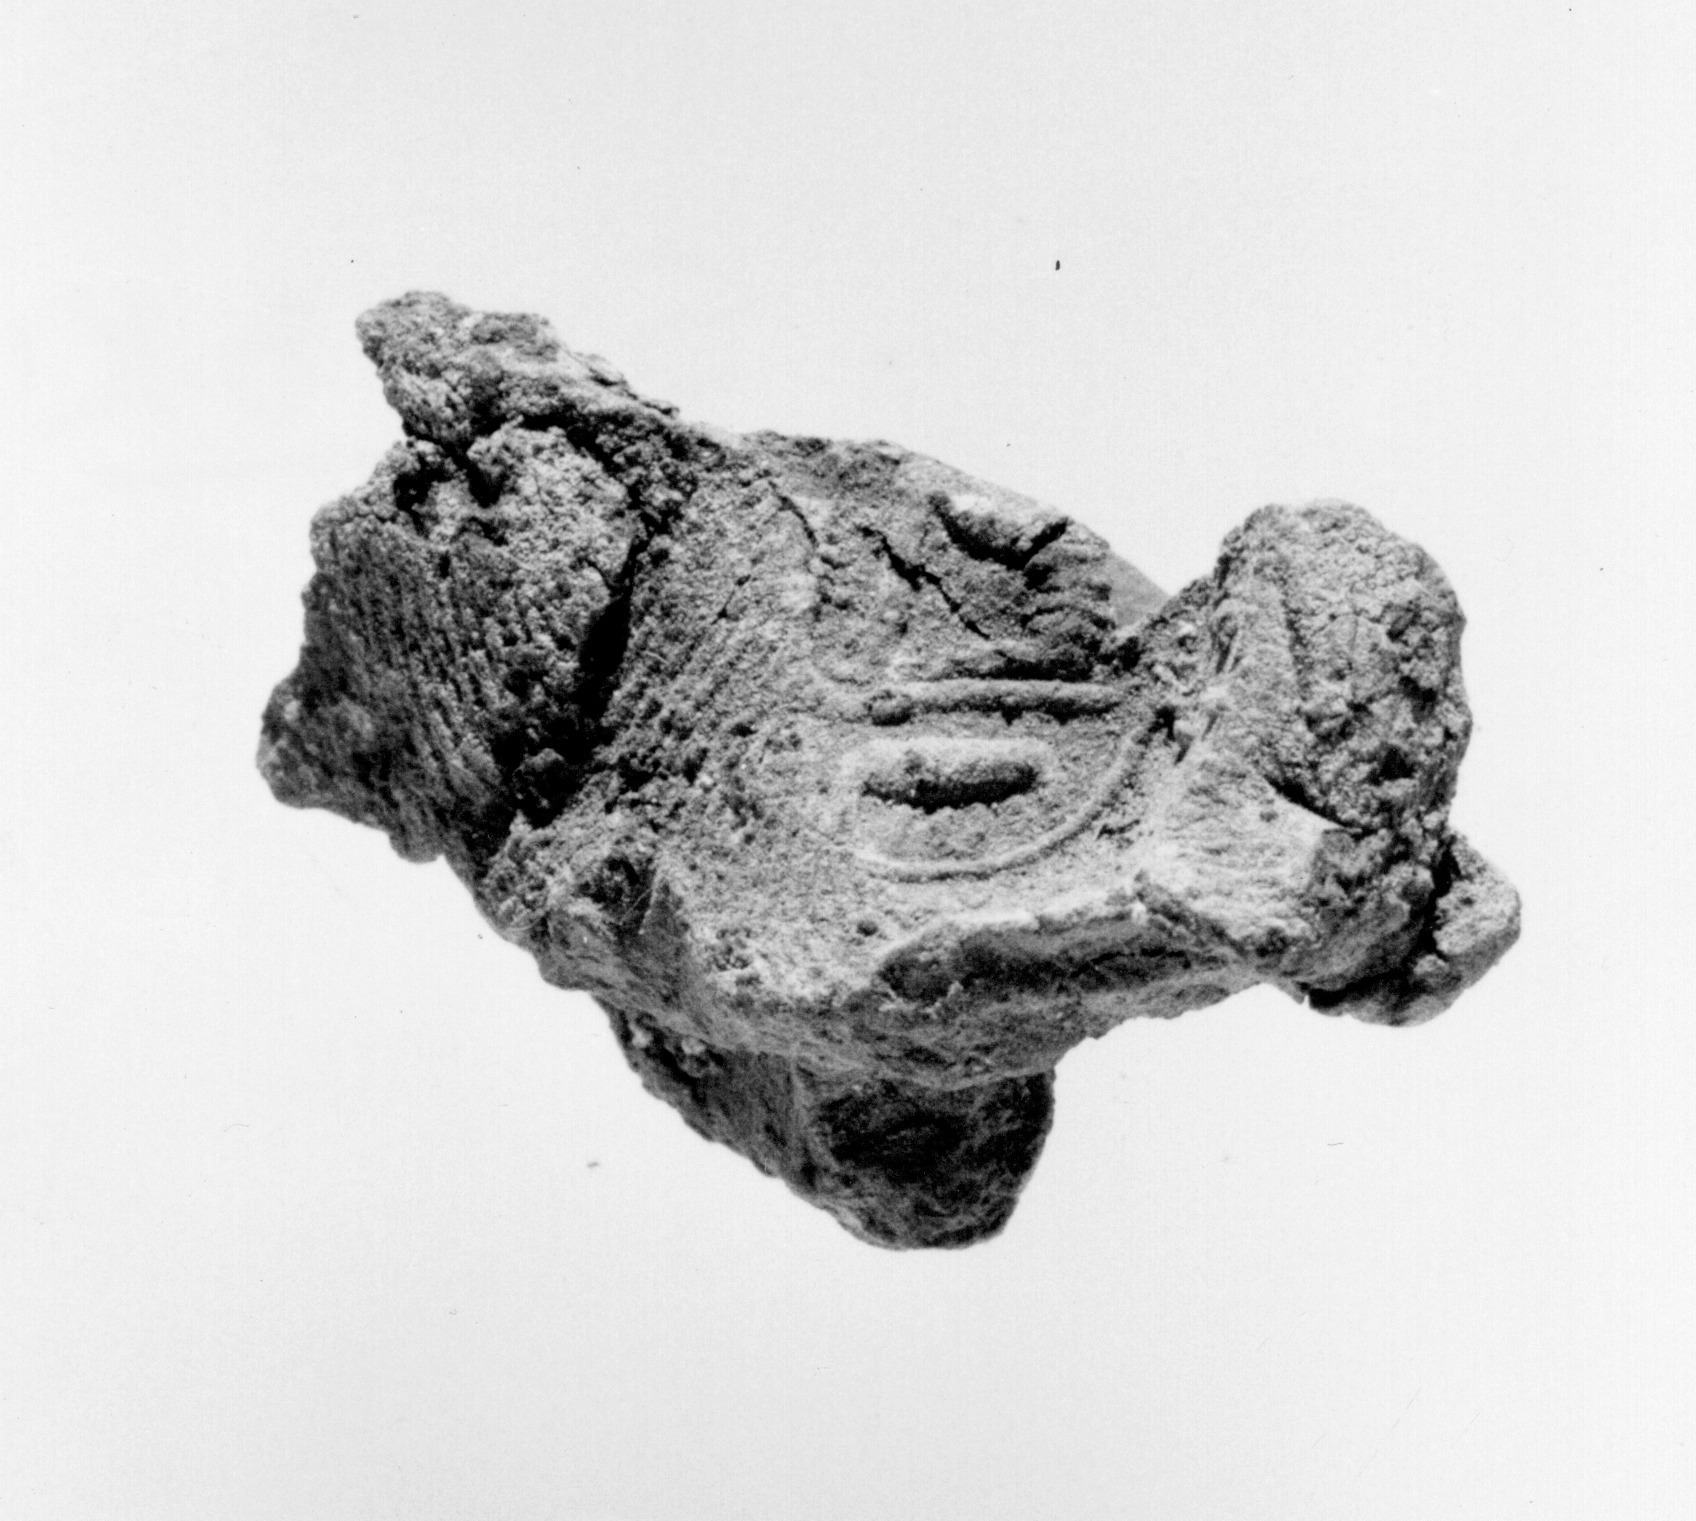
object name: sealing, seth animal, double crown, cobra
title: Document Sealing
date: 1390-1352 BCE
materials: mud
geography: egypt